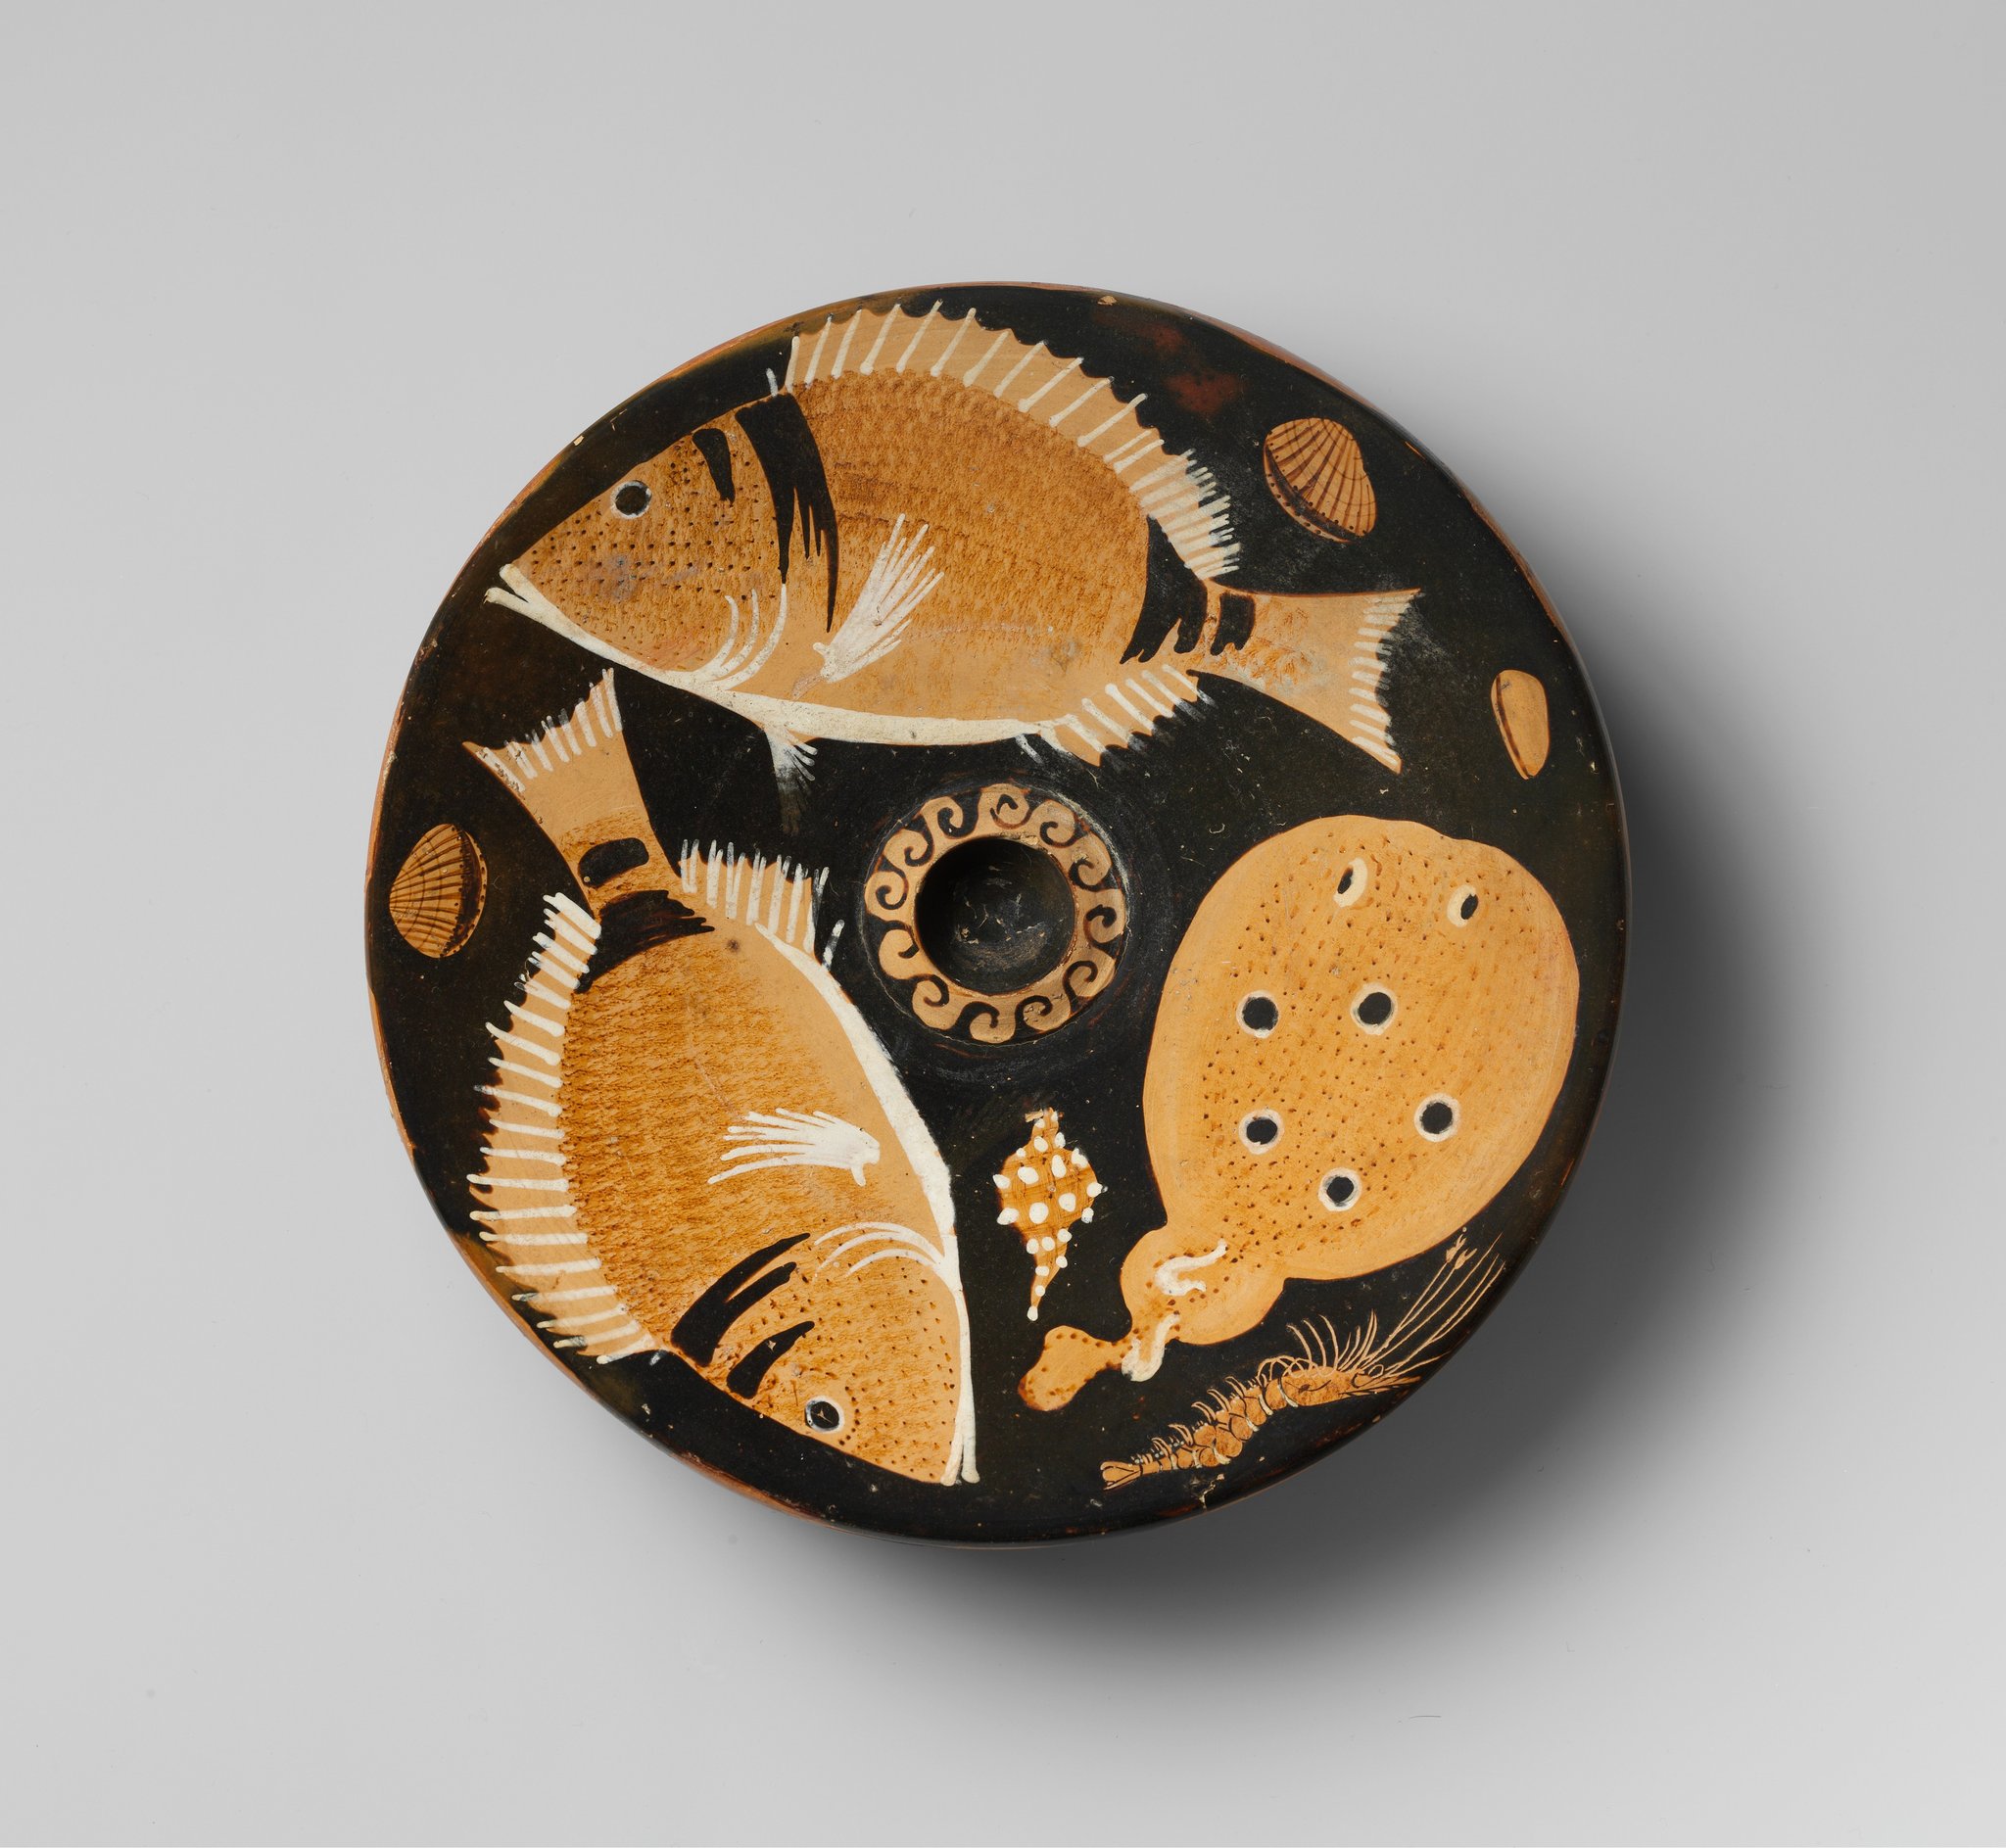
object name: fish plate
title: Terracotta fish-plate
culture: greek or south italian or campanian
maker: helgoland painter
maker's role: artist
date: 350-325 BCE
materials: terracotta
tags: fish,shells